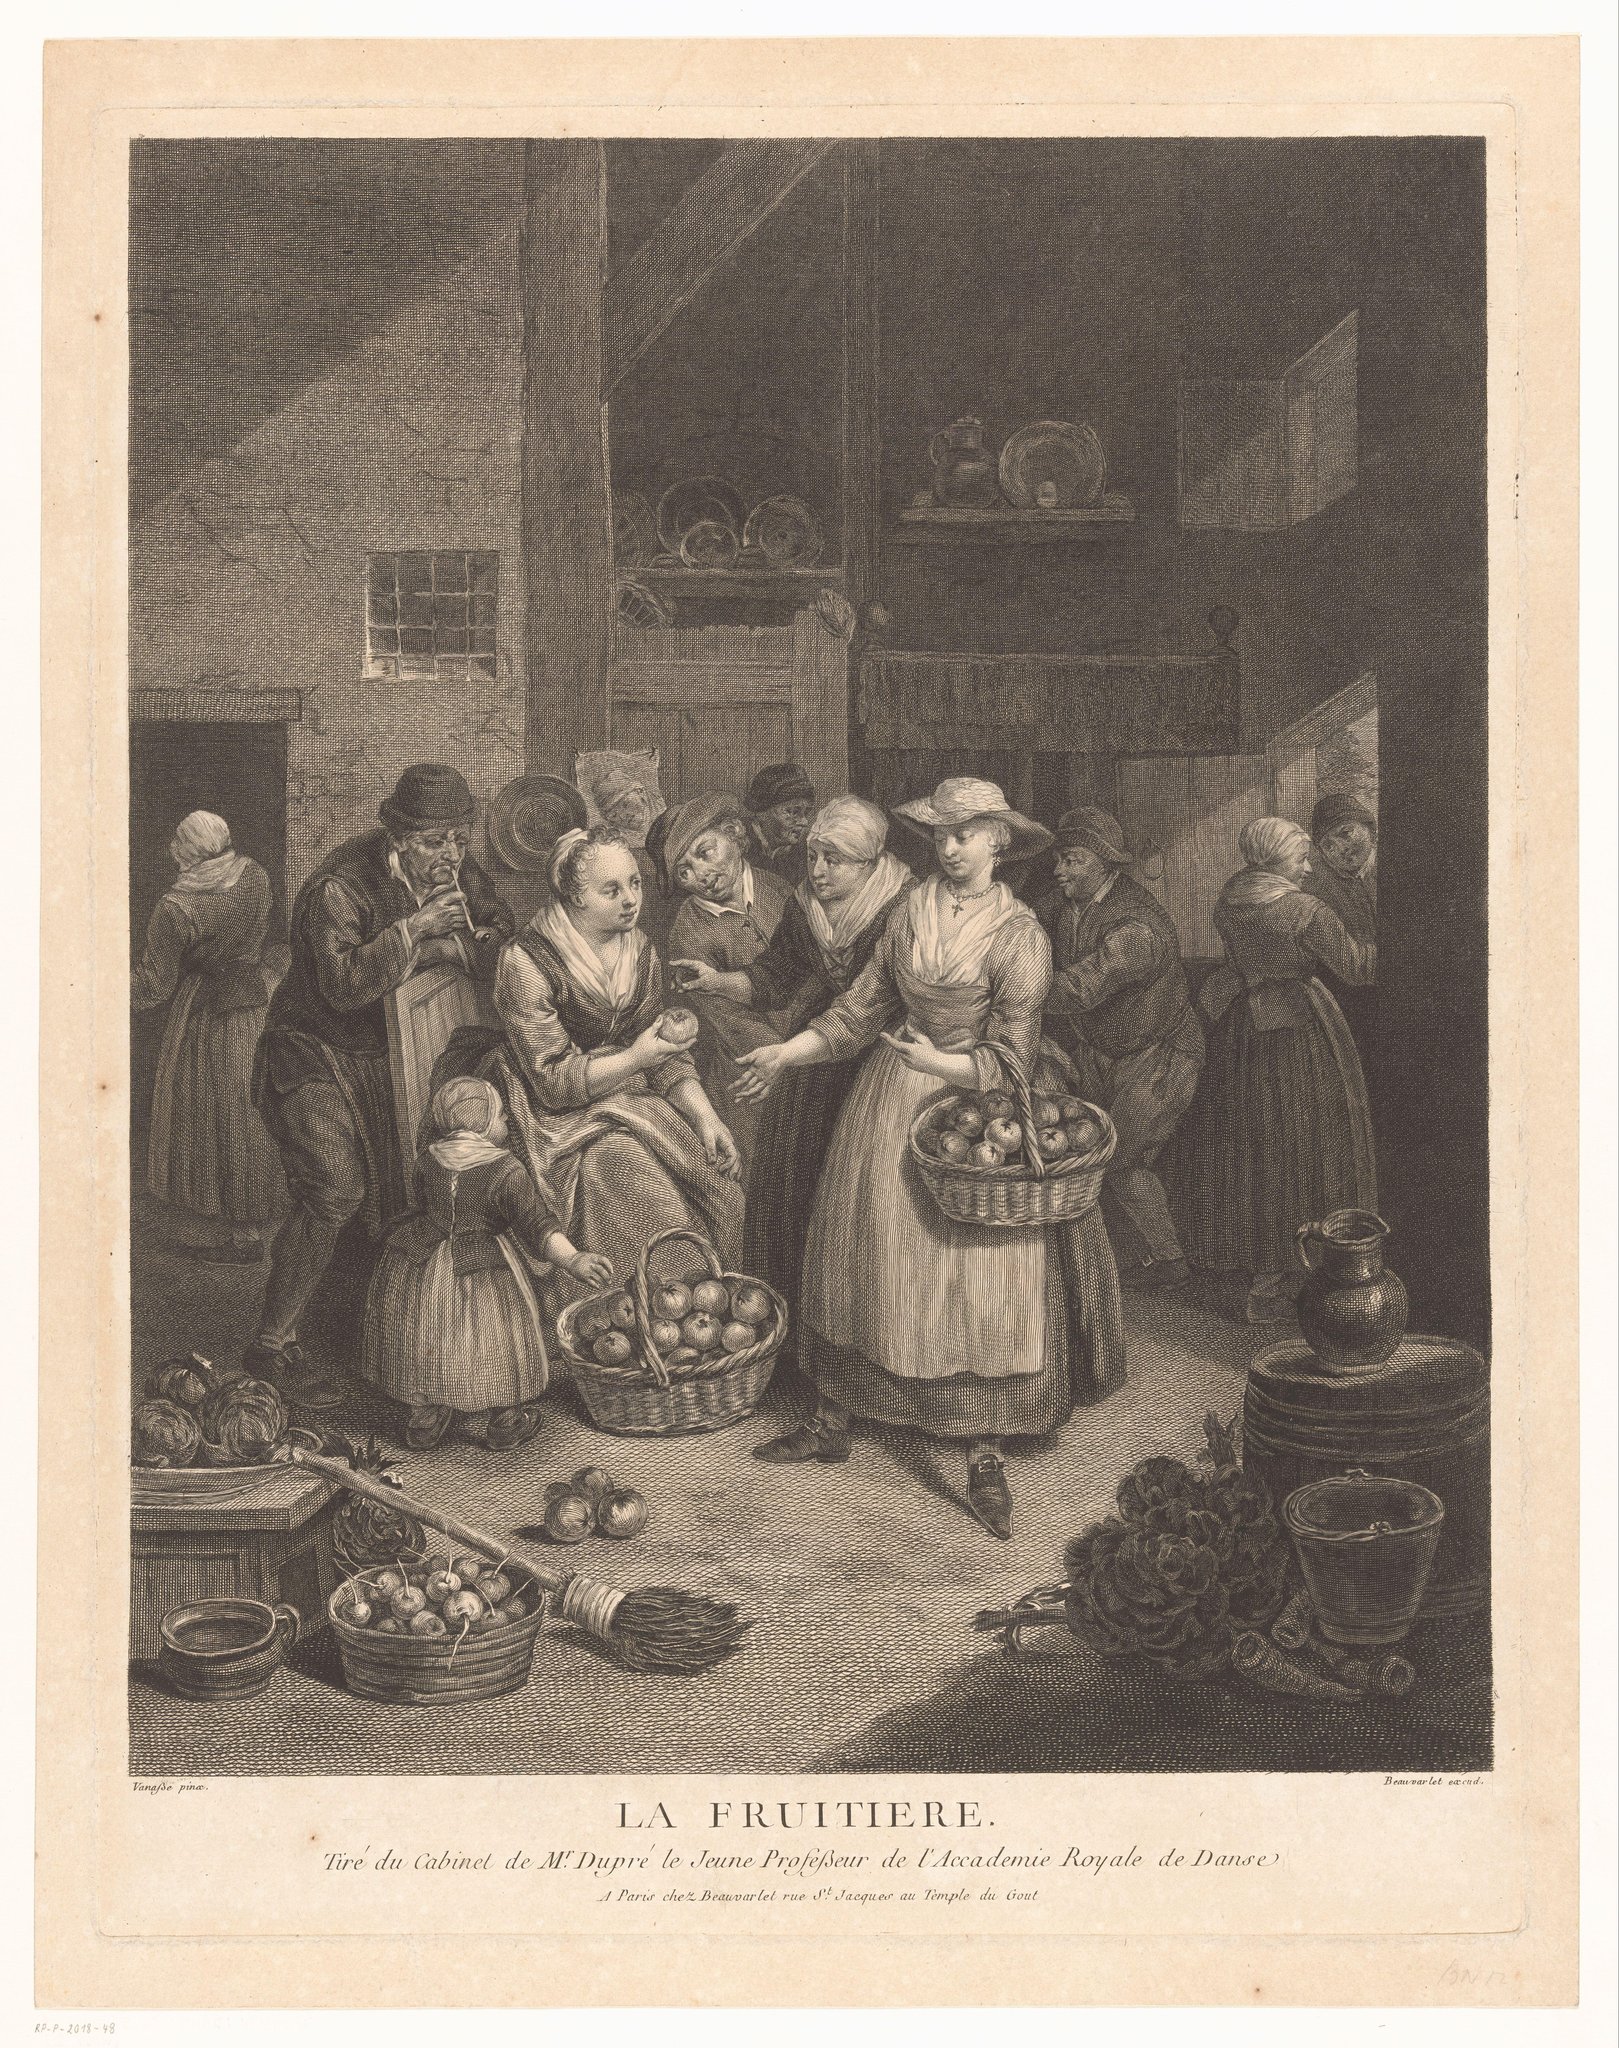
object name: print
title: Fruitverkoopster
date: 1741-1797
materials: paper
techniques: engraving, etching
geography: france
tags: street-trader - bb - women engaged in trade and commerce, fruit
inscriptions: collector's mark: Lugt 2228